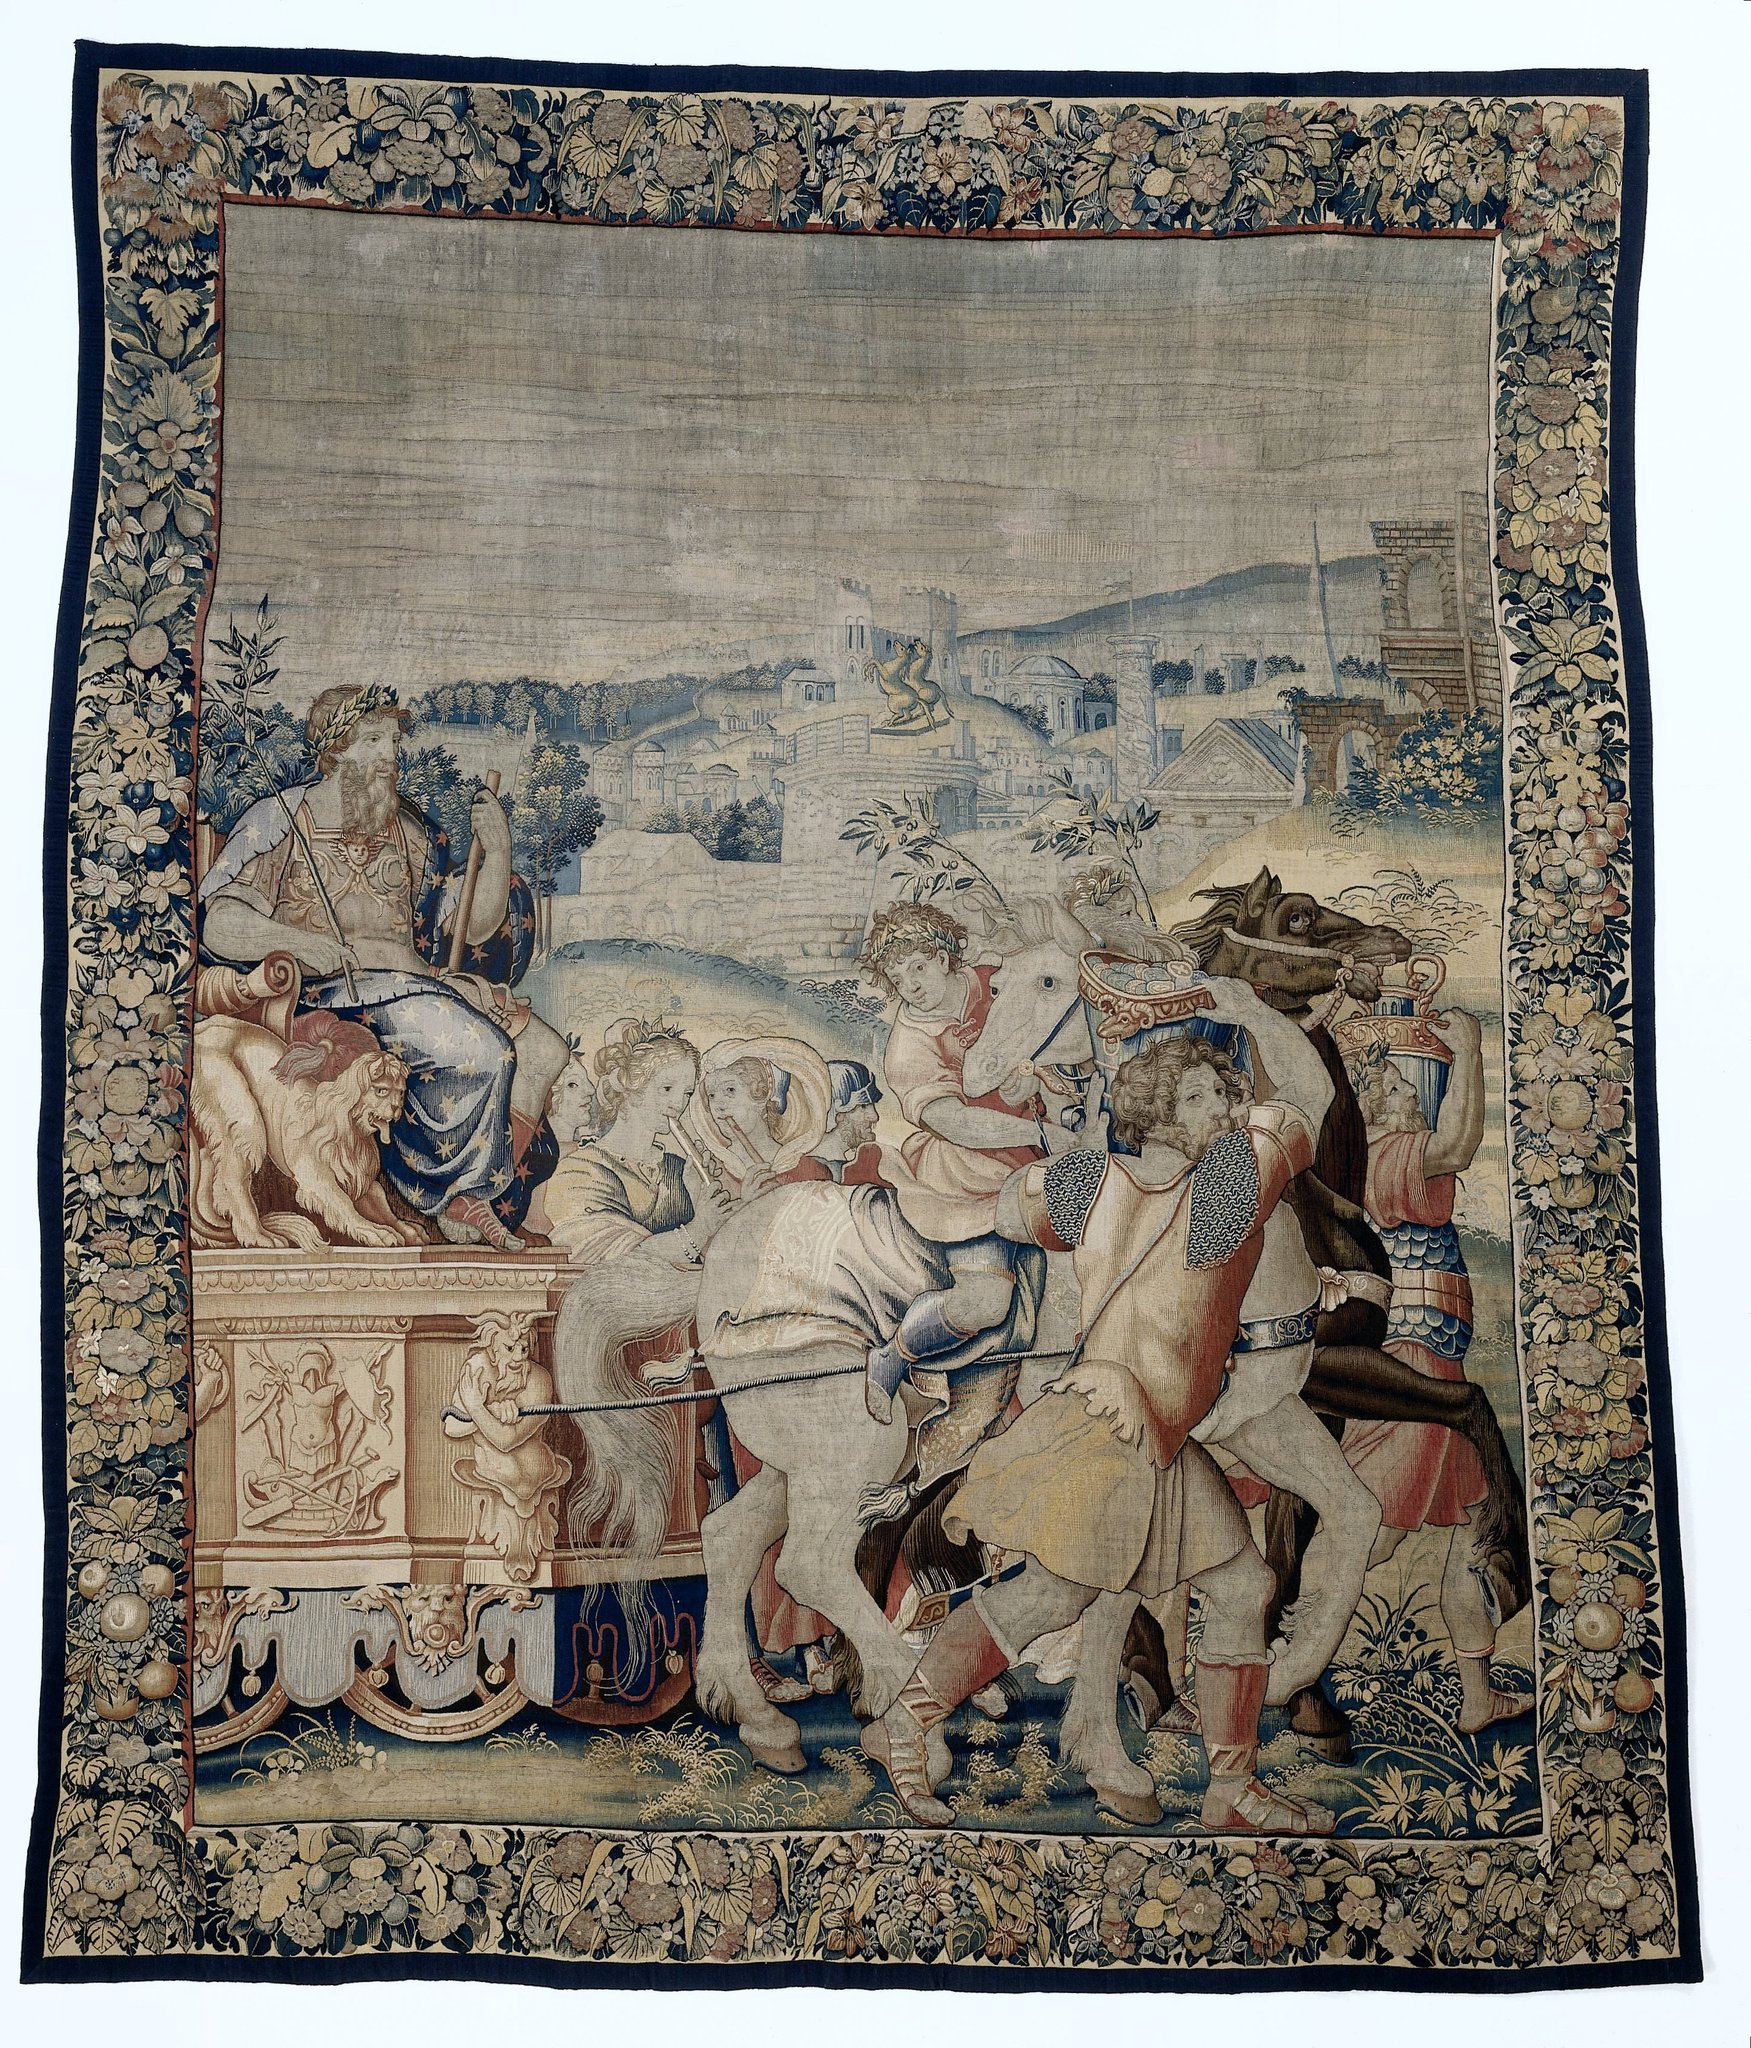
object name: tapestry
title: De triomf van Scipio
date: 1550-1575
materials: silk, wool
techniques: tapestry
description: Wandtapijt met de Triomf van Scipio en de Monte Cavallo. Mogelijk uit een Scipio-serie naar Giulio Romano.